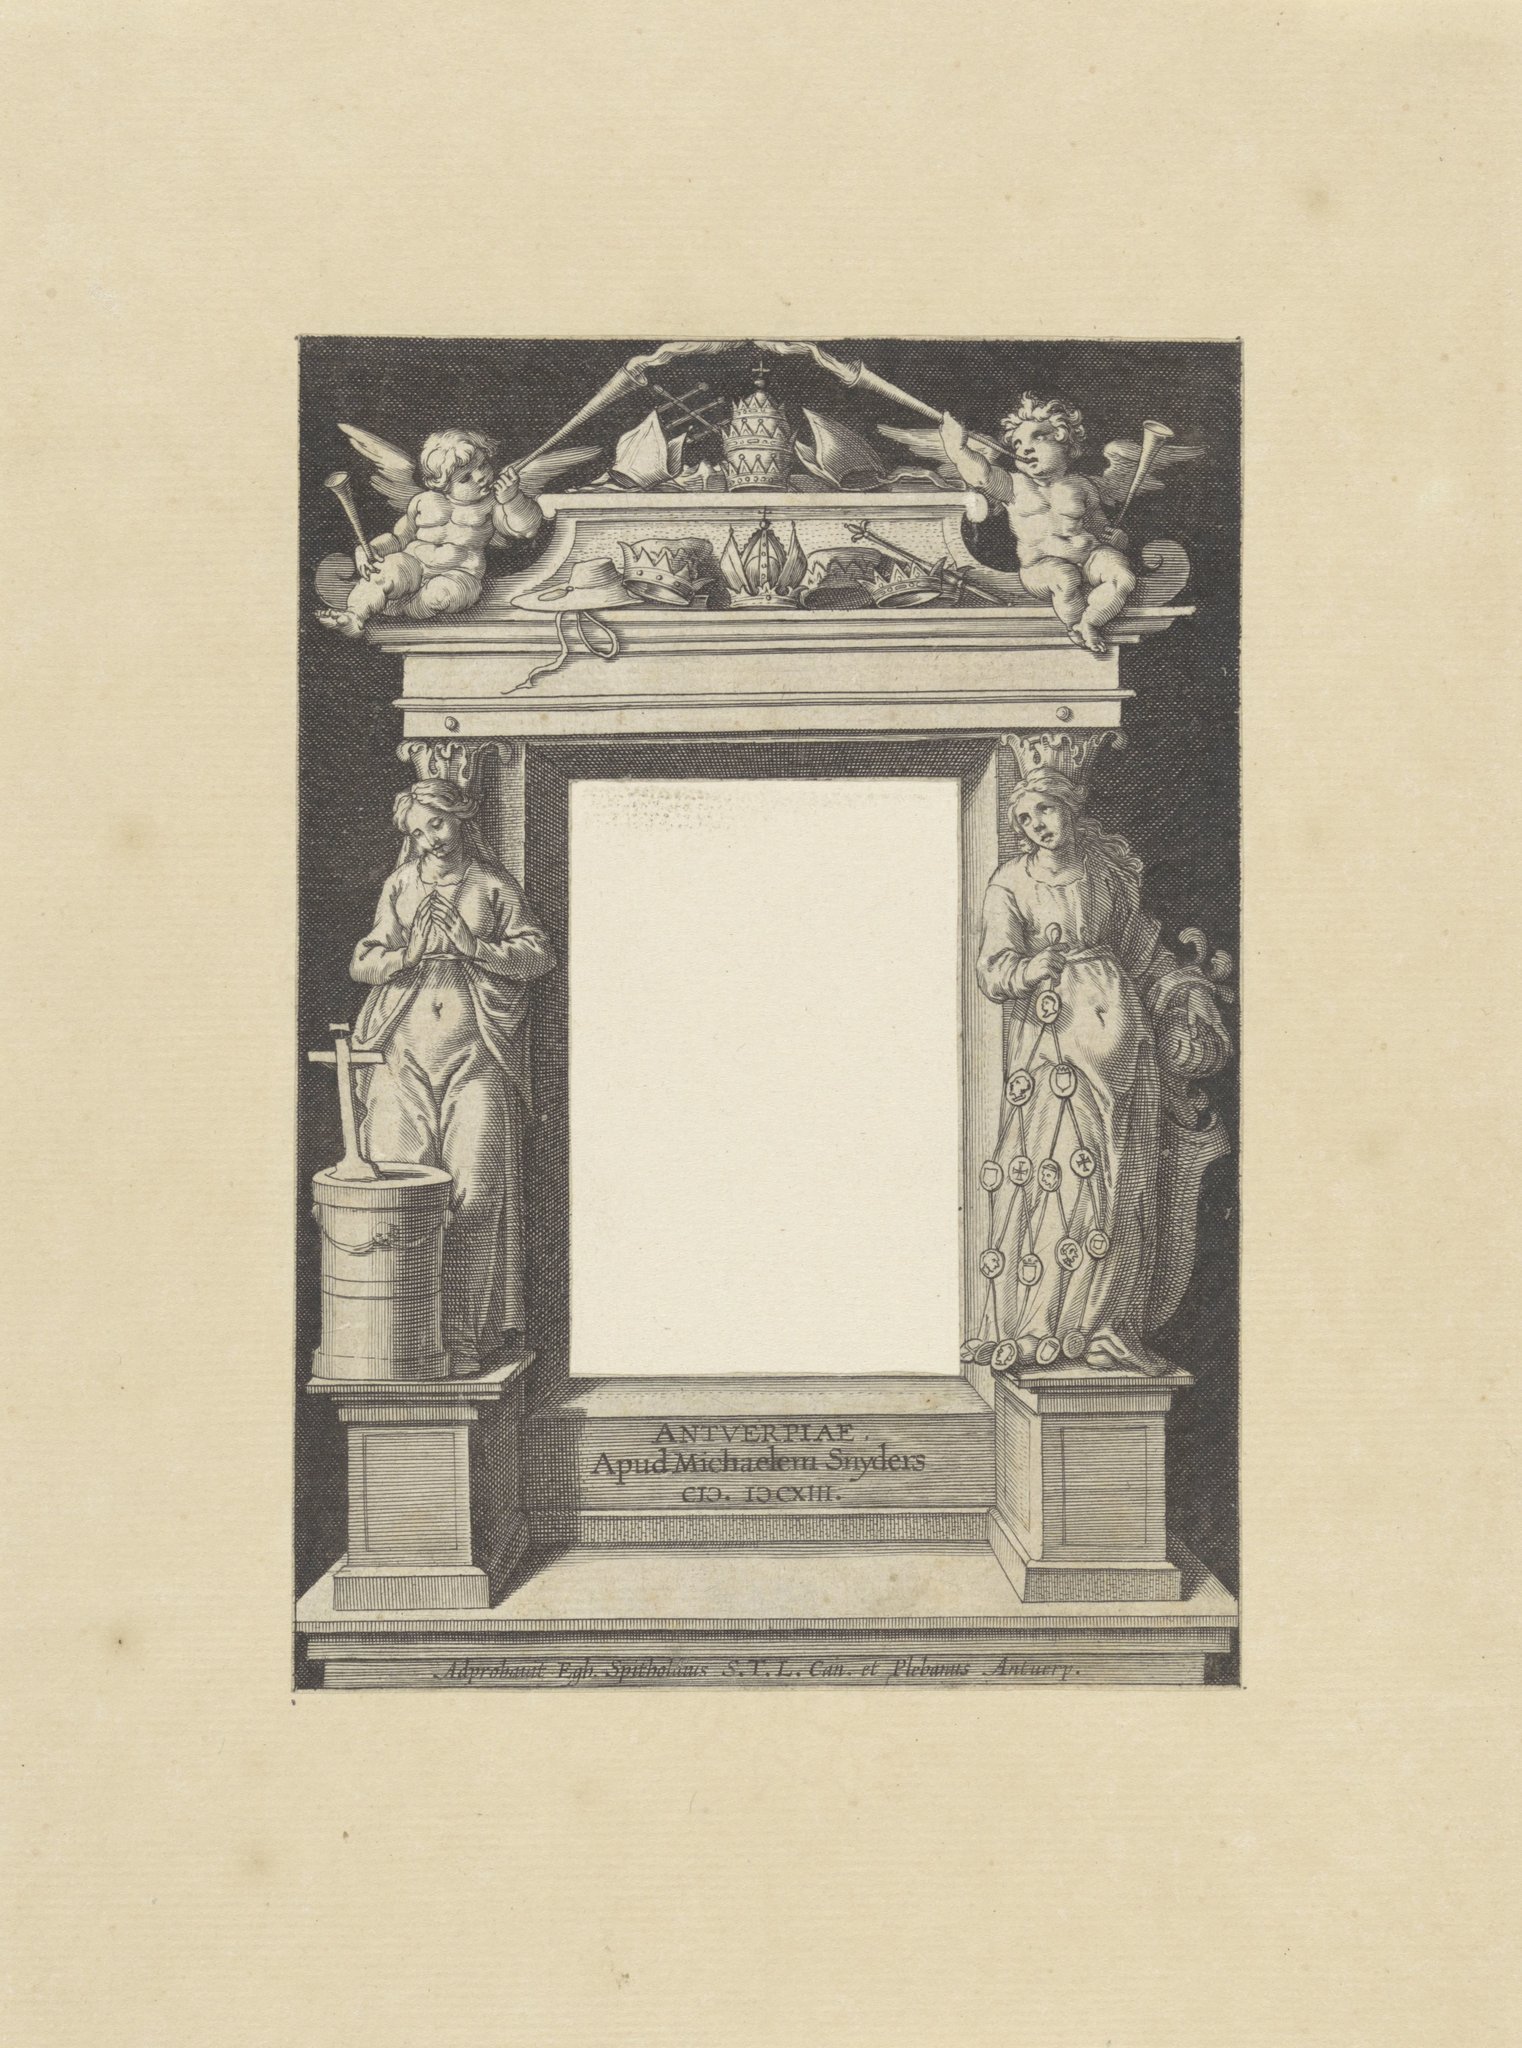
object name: titelblad, titelpagina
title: Titelpagina voor: Sanctorum principum regum atq. impp. imagines (...), 1613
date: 1613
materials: paper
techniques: engraving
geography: antwerp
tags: crown (symbol of sovereignty), faith, 'fides'; 'fede', 'fede catholica', 'fede christiana', 'fede christiana catholica' (ripa) ~ one of the three theological virtues, cupids: 'amores', 'amoretti', 'putti', (allegory on) papacy and apostolic succession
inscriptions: collector's mark: Lugt 2228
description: Allegorische voorstelling met Fides en Opvolging, die in haar hand een "stamboom van aaneengeknoopte portretten en familiewapens vasthoudt. Bovenaan twee putti die op trompetten blazen. Tussen hen in enkele wereldlijke en kerkelijke kronen en hoofddeksels. De titel van het boek is uit de omlijsting gesneden.